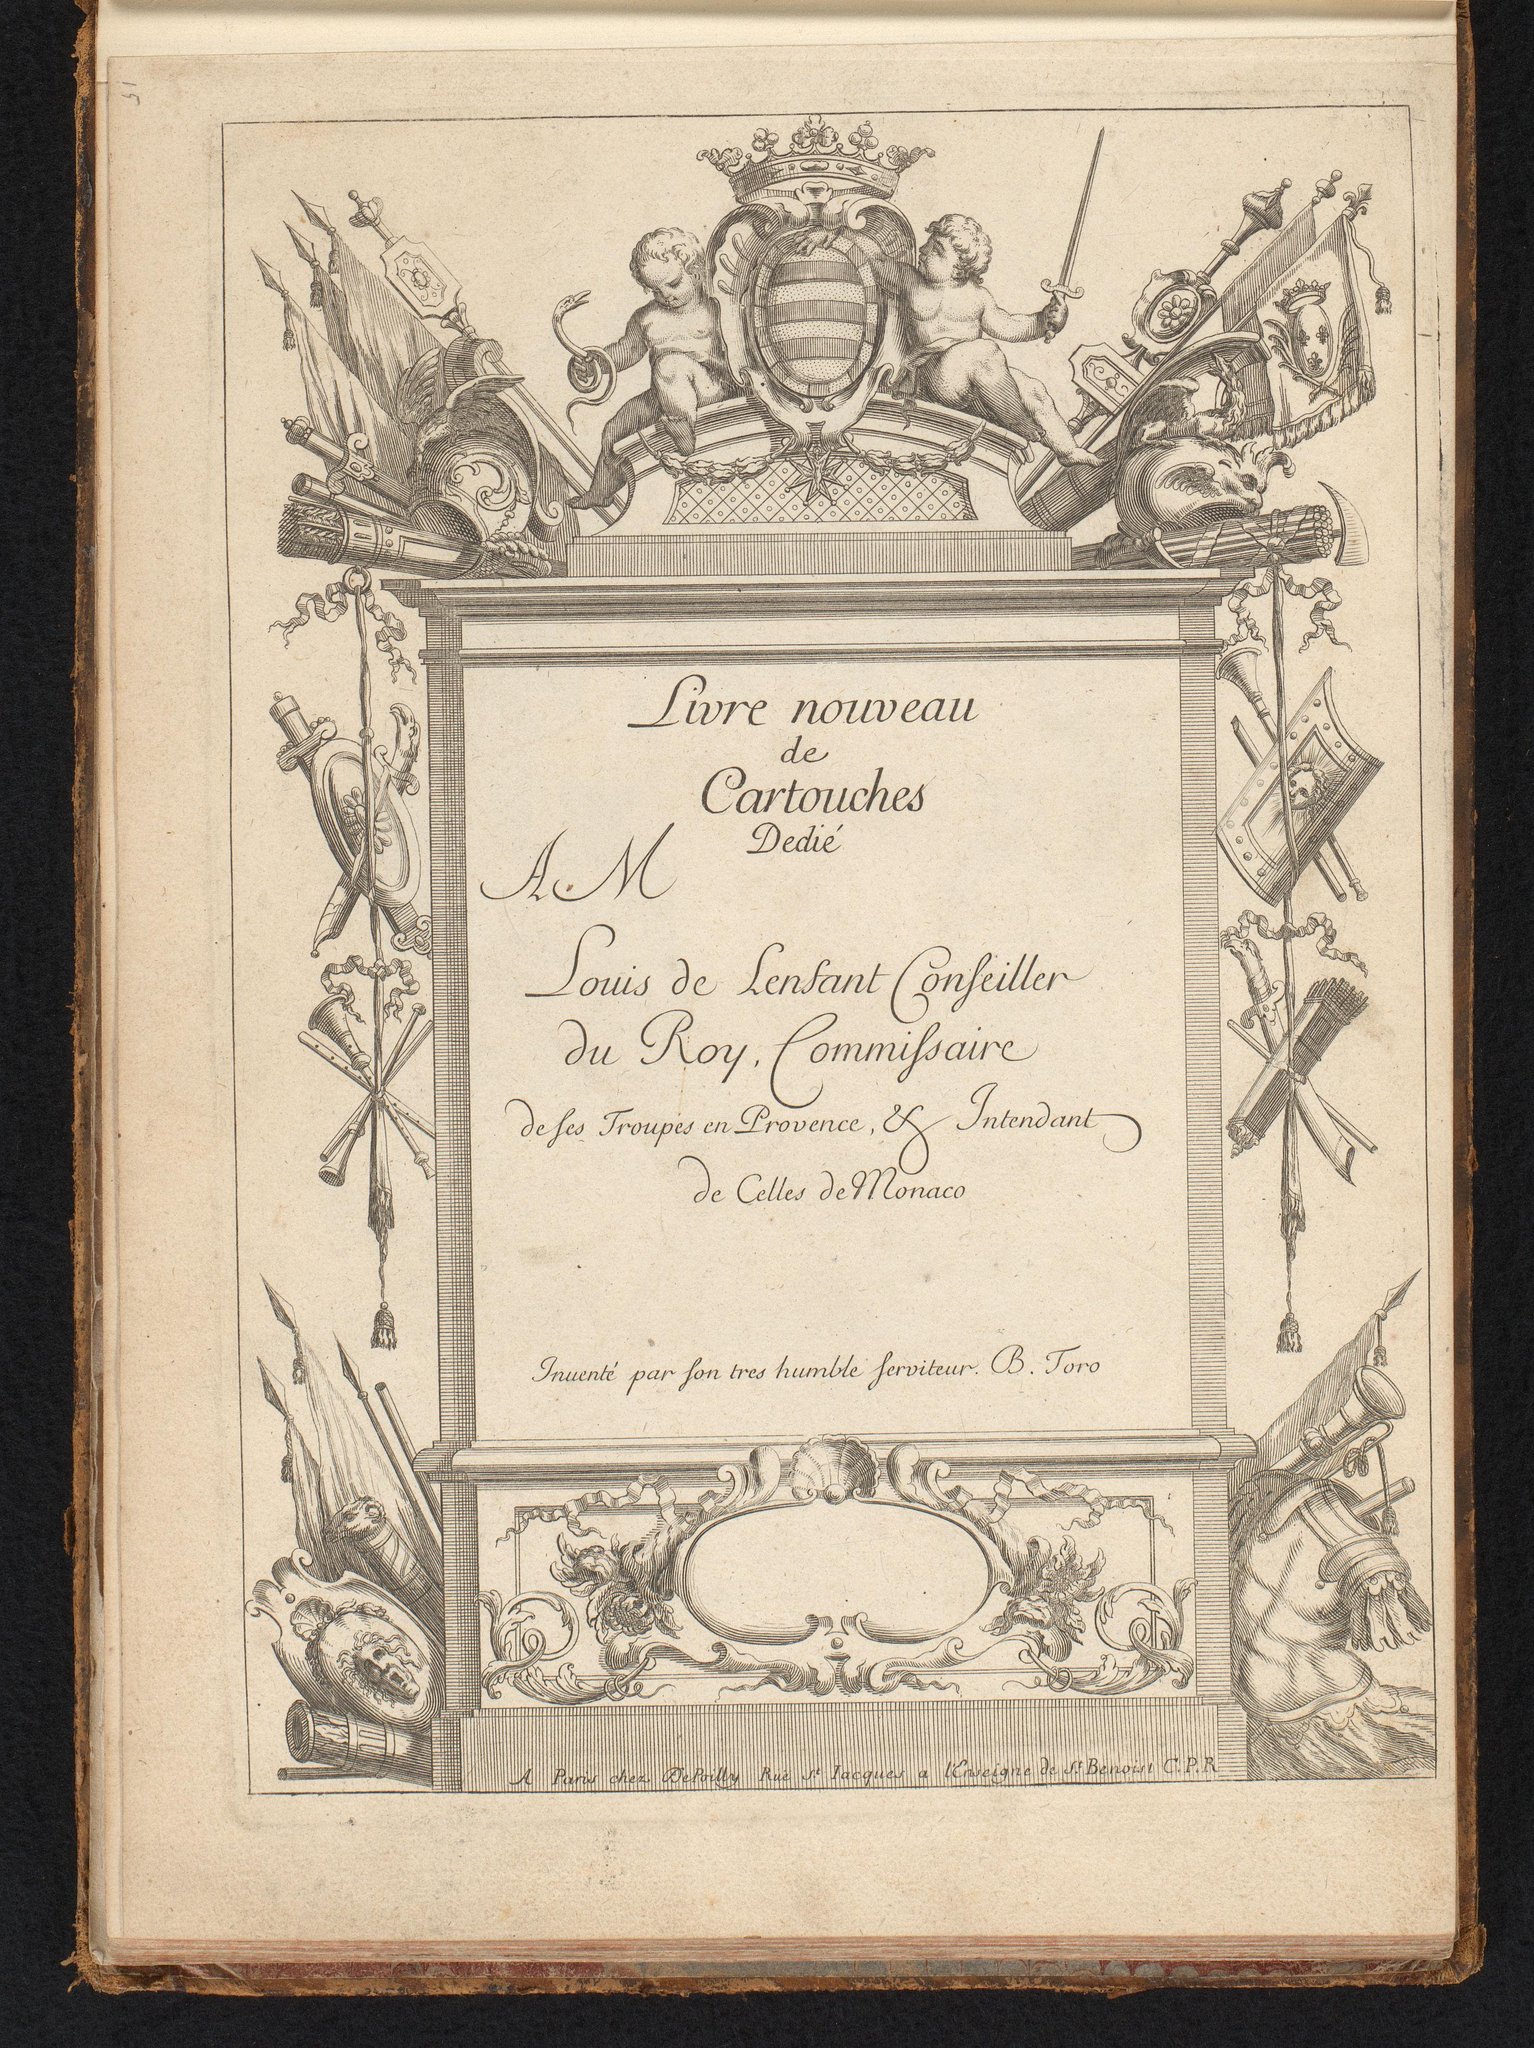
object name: ornament print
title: Ontwerpen voor cartouches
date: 1682-1723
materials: paper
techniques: etching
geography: france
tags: 'tropaion', i.e. decorative ornament ~ weapons, cupids: 'amores', 'amoretti', 'putti'